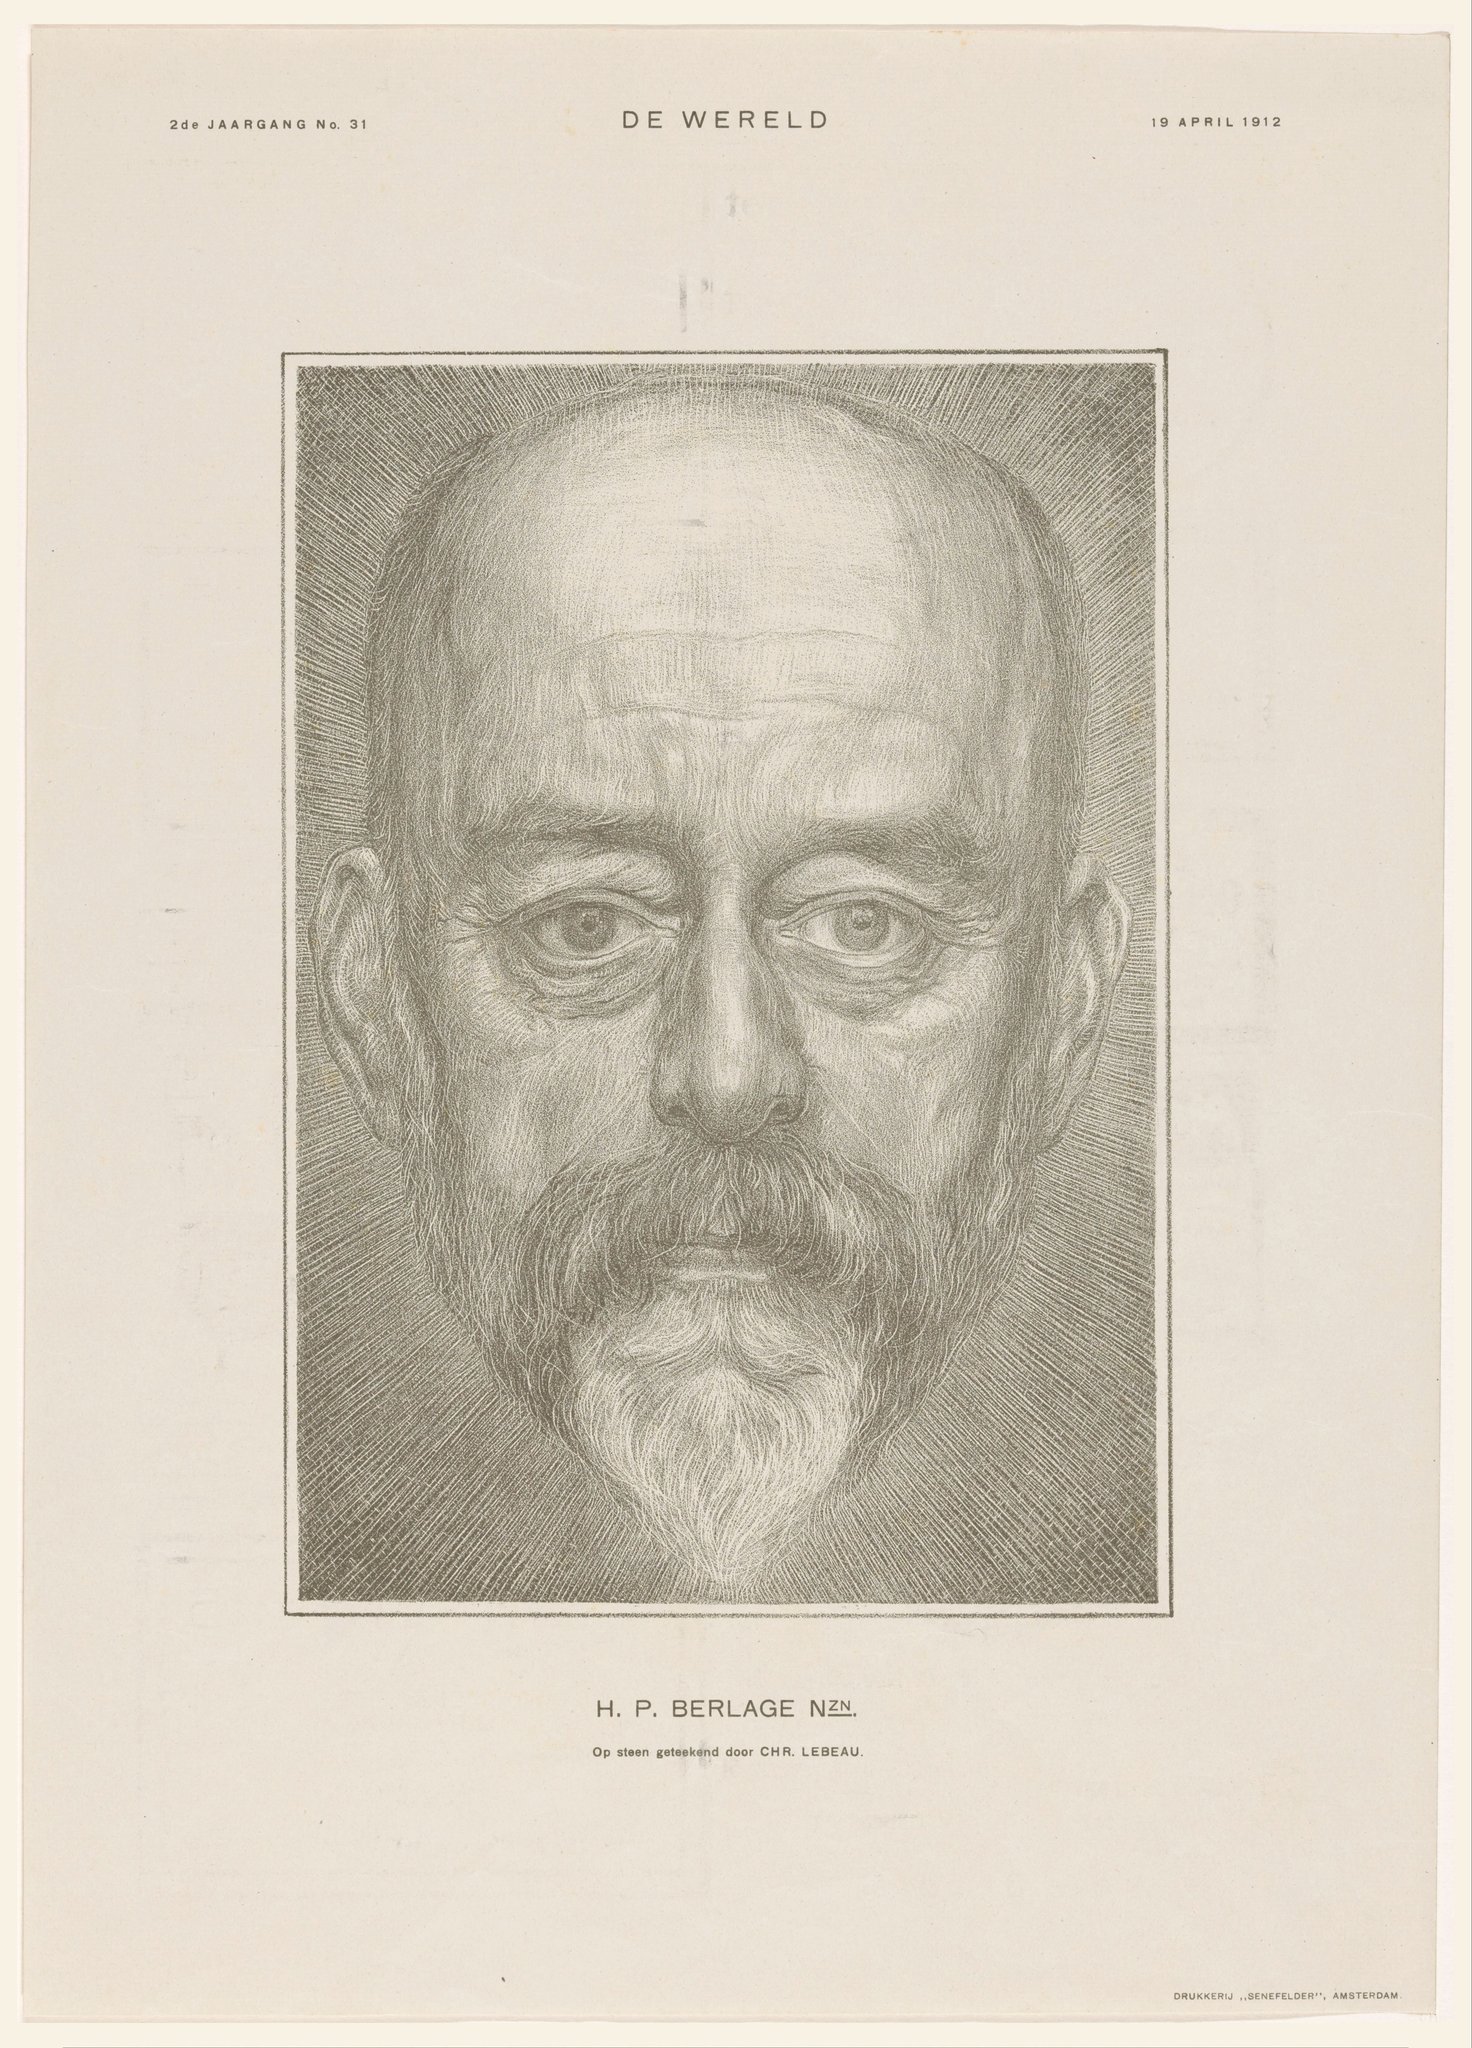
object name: print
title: Portret van H.P. Berlage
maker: chris lebeau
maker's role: draughtsman, print maker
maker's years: 1878-1945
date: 1912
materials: paper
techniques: lithograph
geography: amsterdam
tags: amsterdam, the hague, draughtsman, hendrik petrus berlage, portrait, self-portrait of architect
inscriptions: collector's mark: Lugt 2760, collector's mark: Lugt 2228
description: Prent afkomstig uit: De Wereld. Democratisch-staatkundig en algemeen weekblad. Amsterdam: Elsevier, 2 (1912) 31.